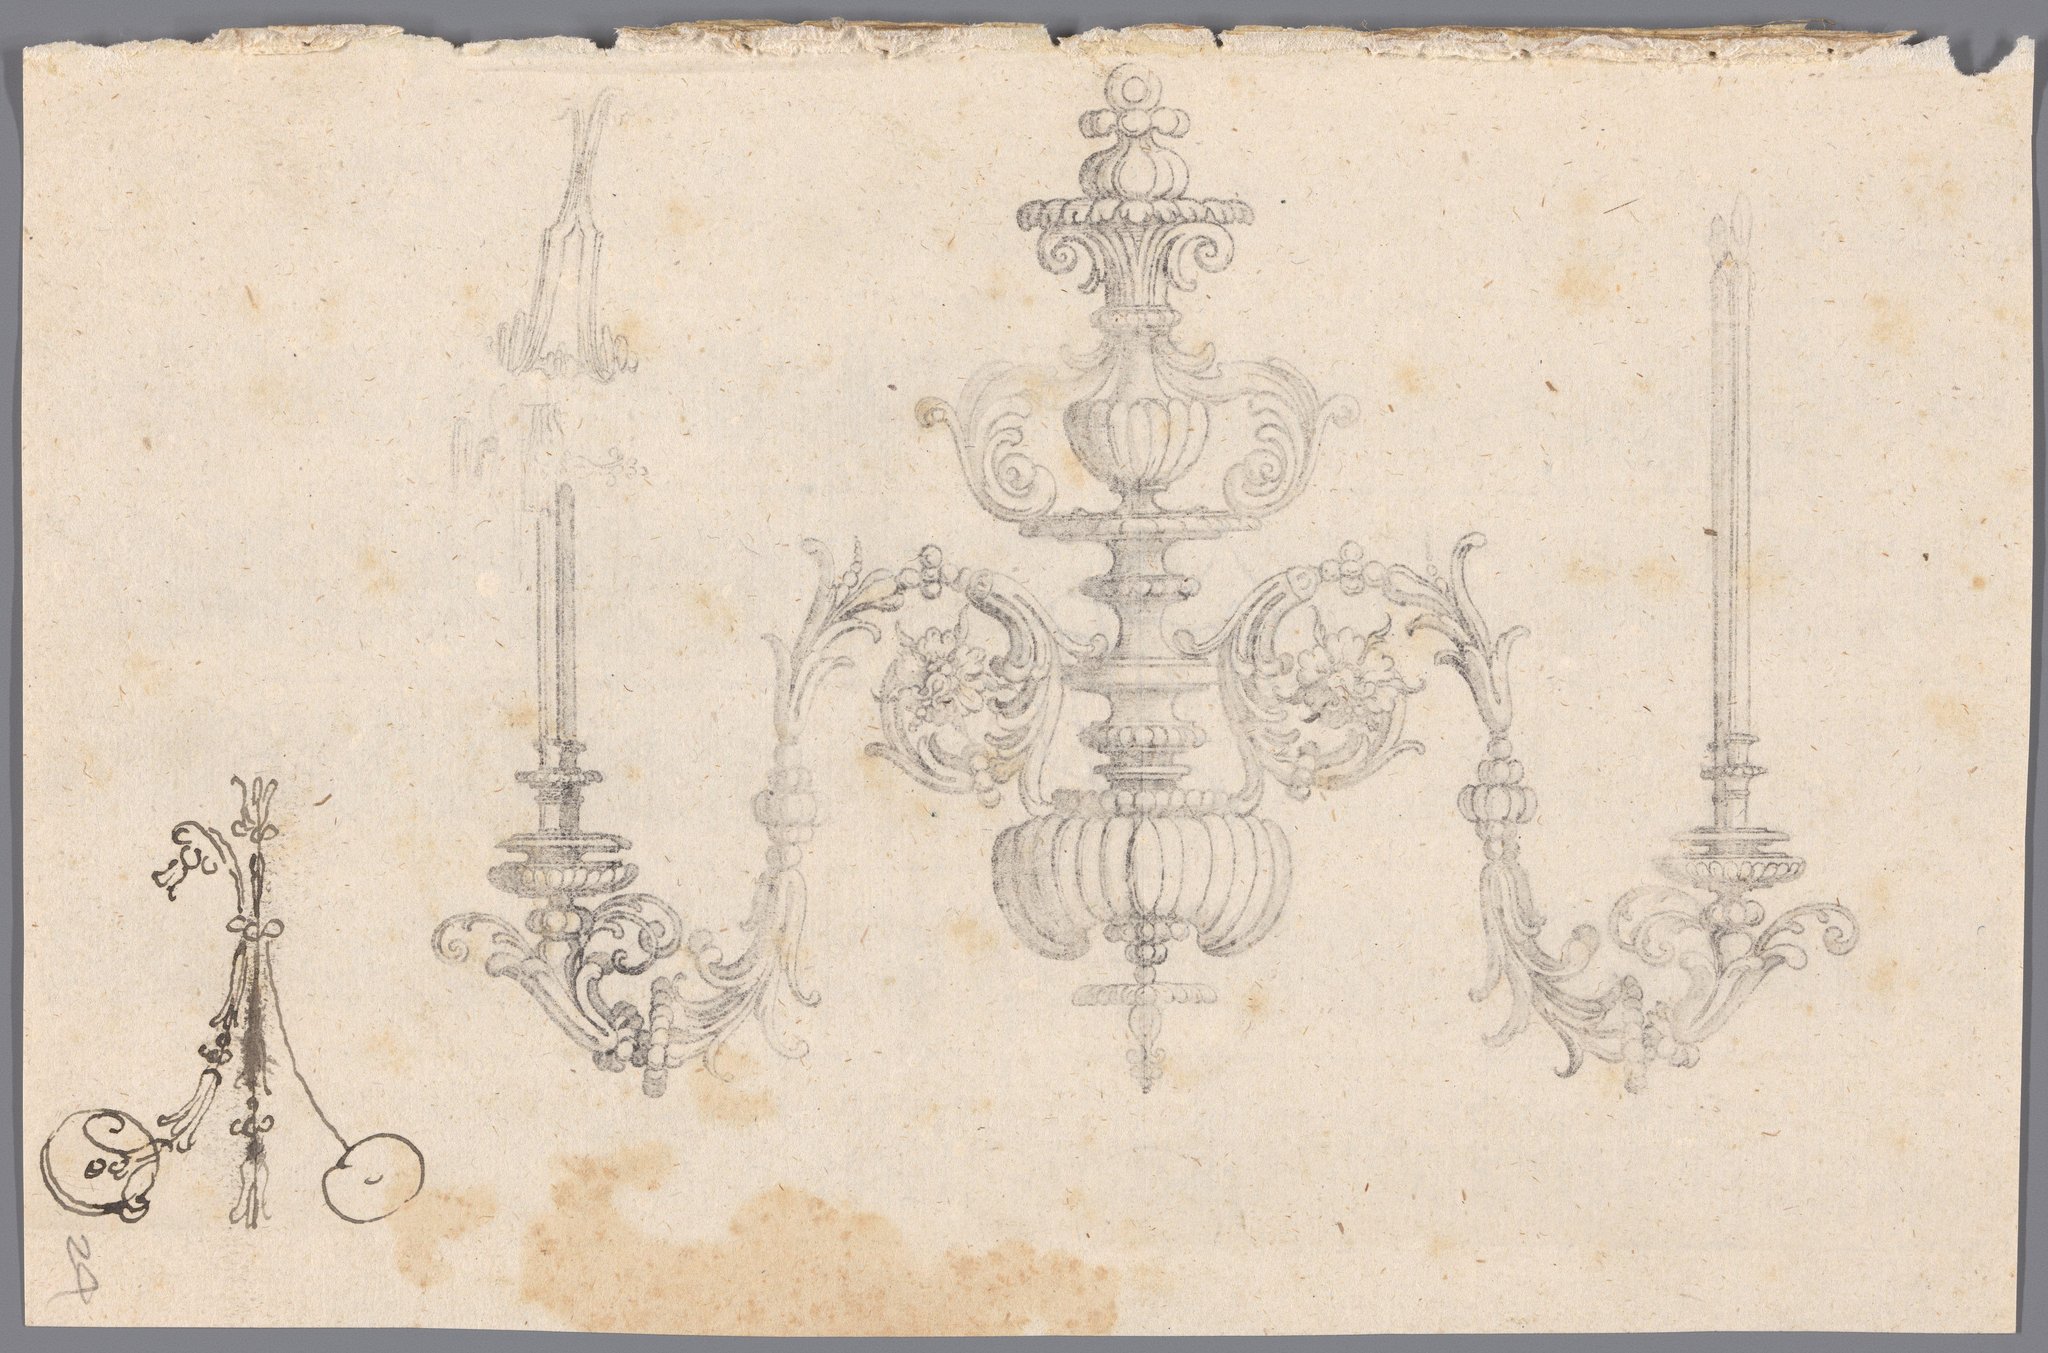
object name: design drawing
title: Afdruk van een tekening van een kroonluchter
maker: Anonymous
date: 1600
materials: ink, paper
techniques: printmaking, pen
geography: germany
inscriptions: number: ‘24’, watermark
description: Linksboven het vooraanzicht van een dubbele voluut; linksonder een schets van een deel van de plattegrond van een arm.